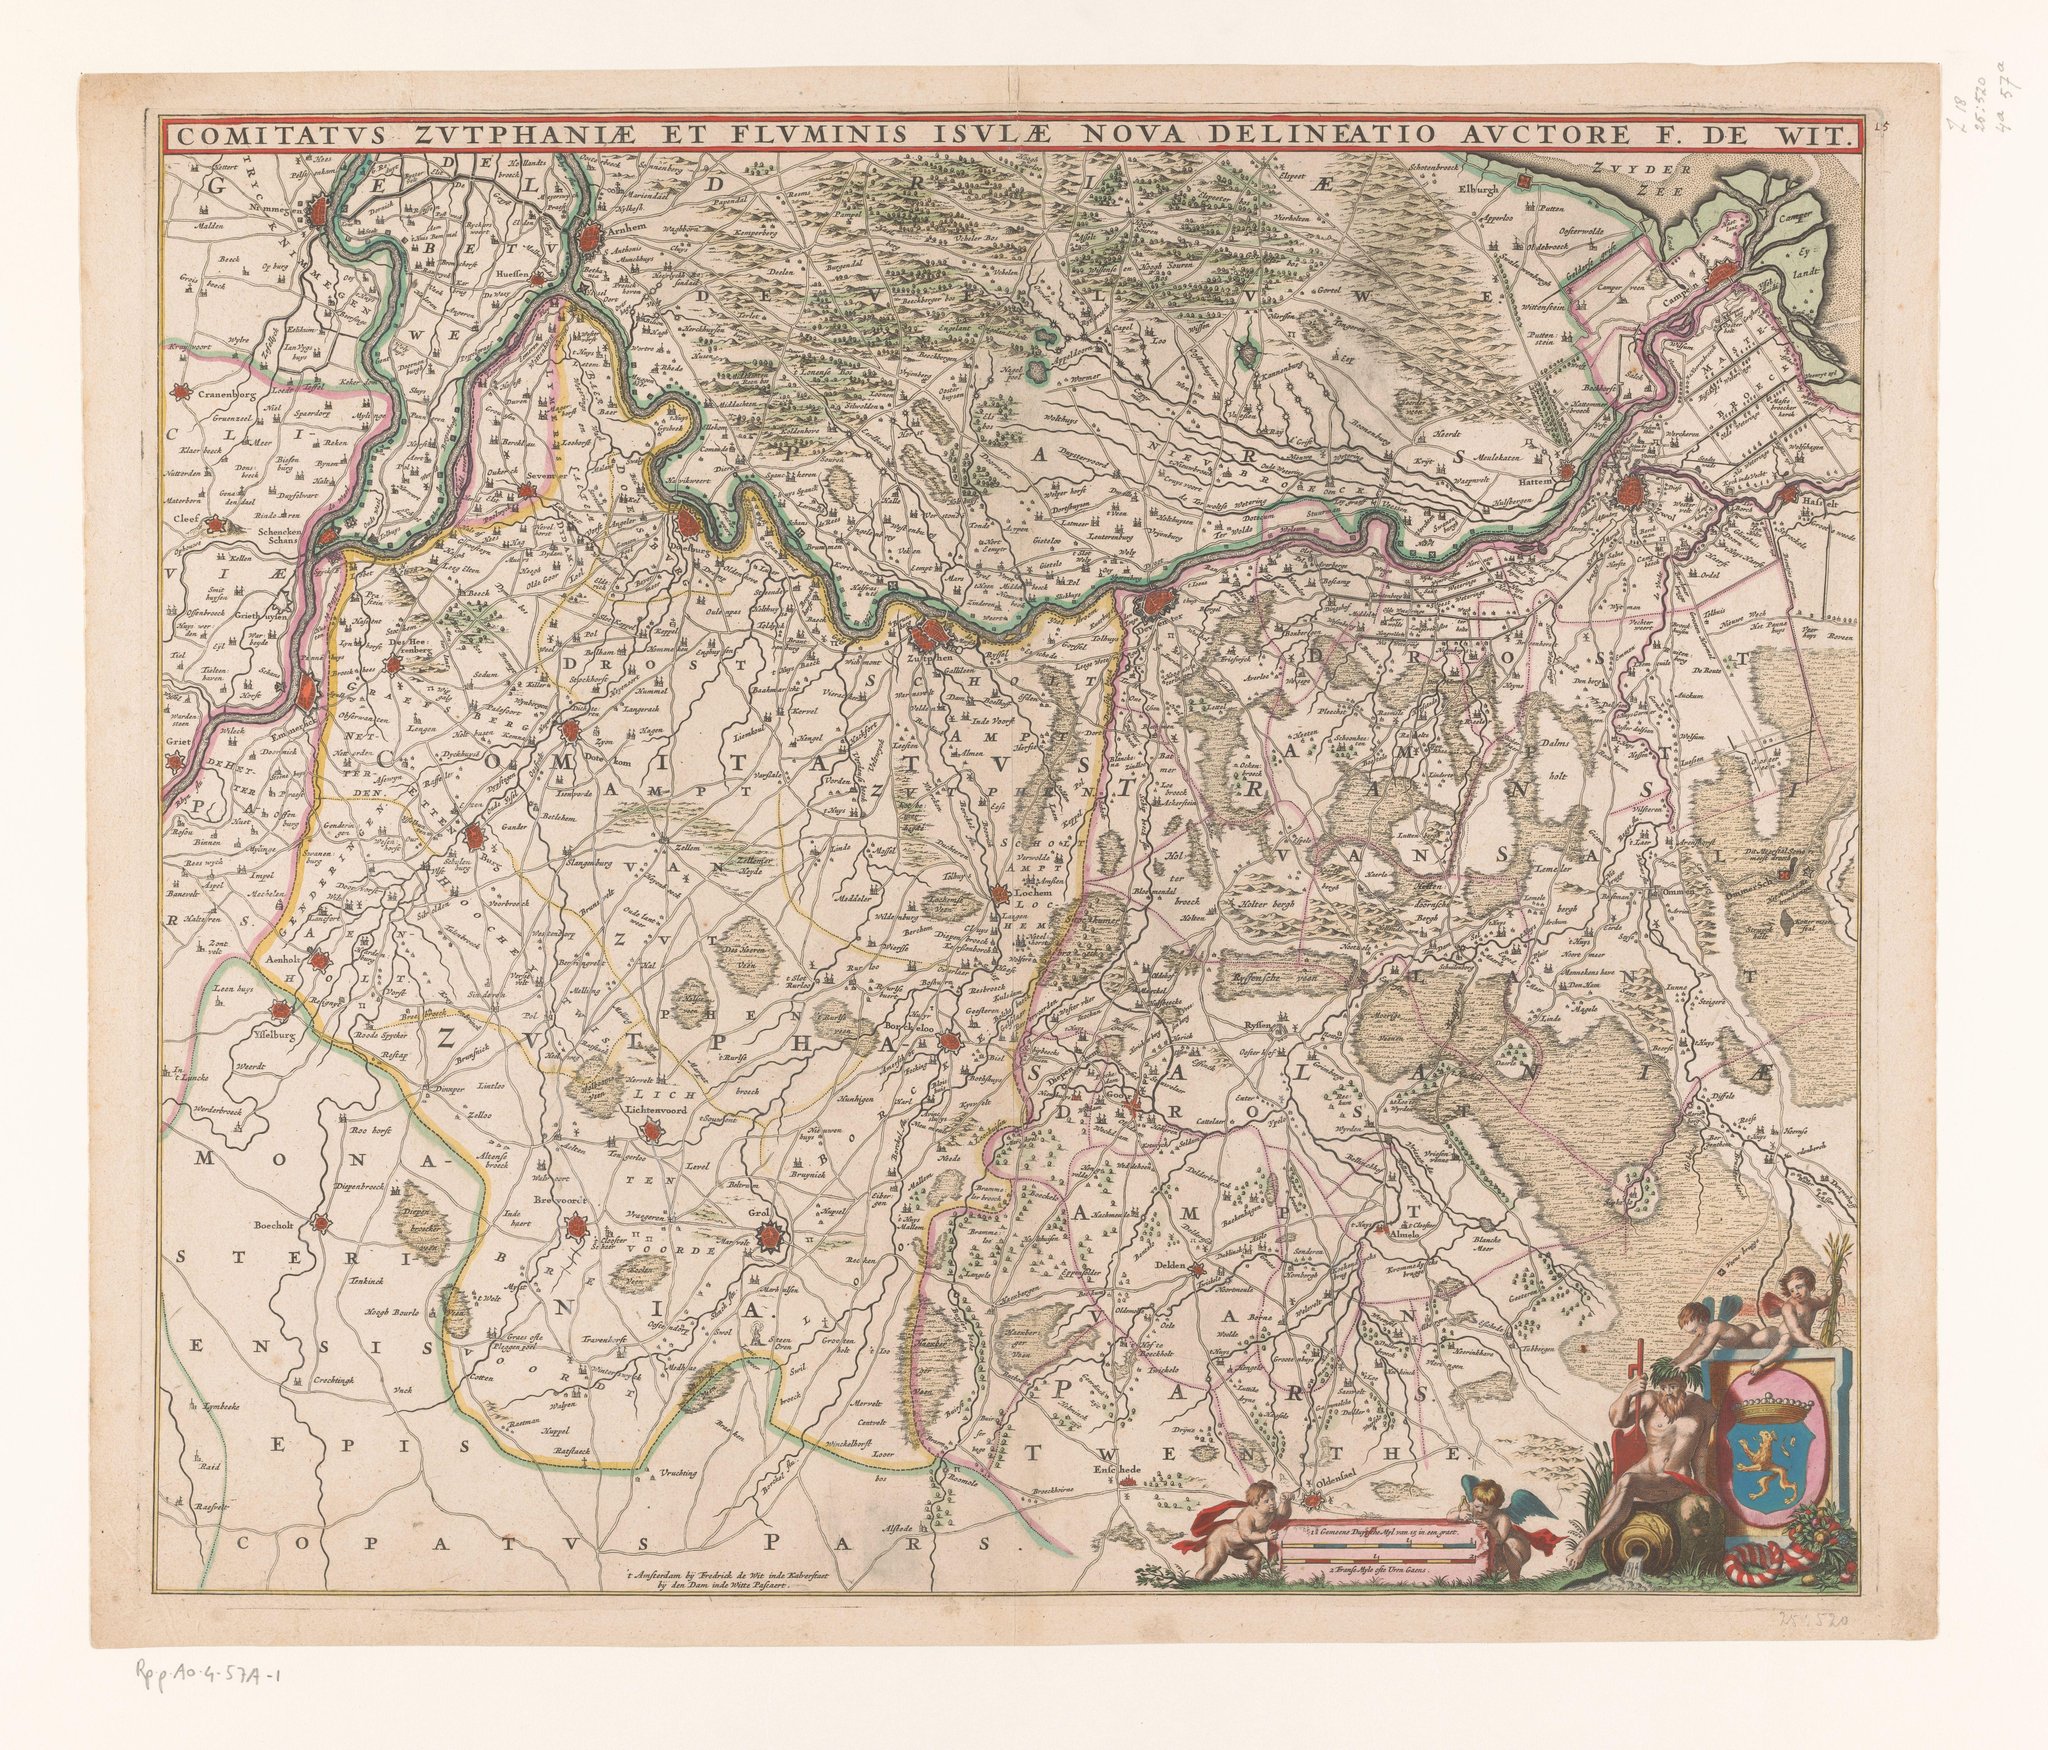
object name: print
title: Kaart van het graafschap Zutphen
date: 1666-1667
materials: paper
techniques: engraving, etching, hand coloring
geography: amsterdam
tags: maps of separate countries or regions, coat of arms (as symbol of the state, etc.) (+ province; provincial), gelderland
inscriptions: collector's mark: Lugt 2228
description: De titel in een balk boven de kaart. Rechtsonder het wapen van het graafschap Zutphen, links daarnaast een cartouche met twee schaalstokken: 1 1/2 Gemeene Duytsche Myl van 15 in een graet / 2 Franse Myle ofte Uren Gaens.